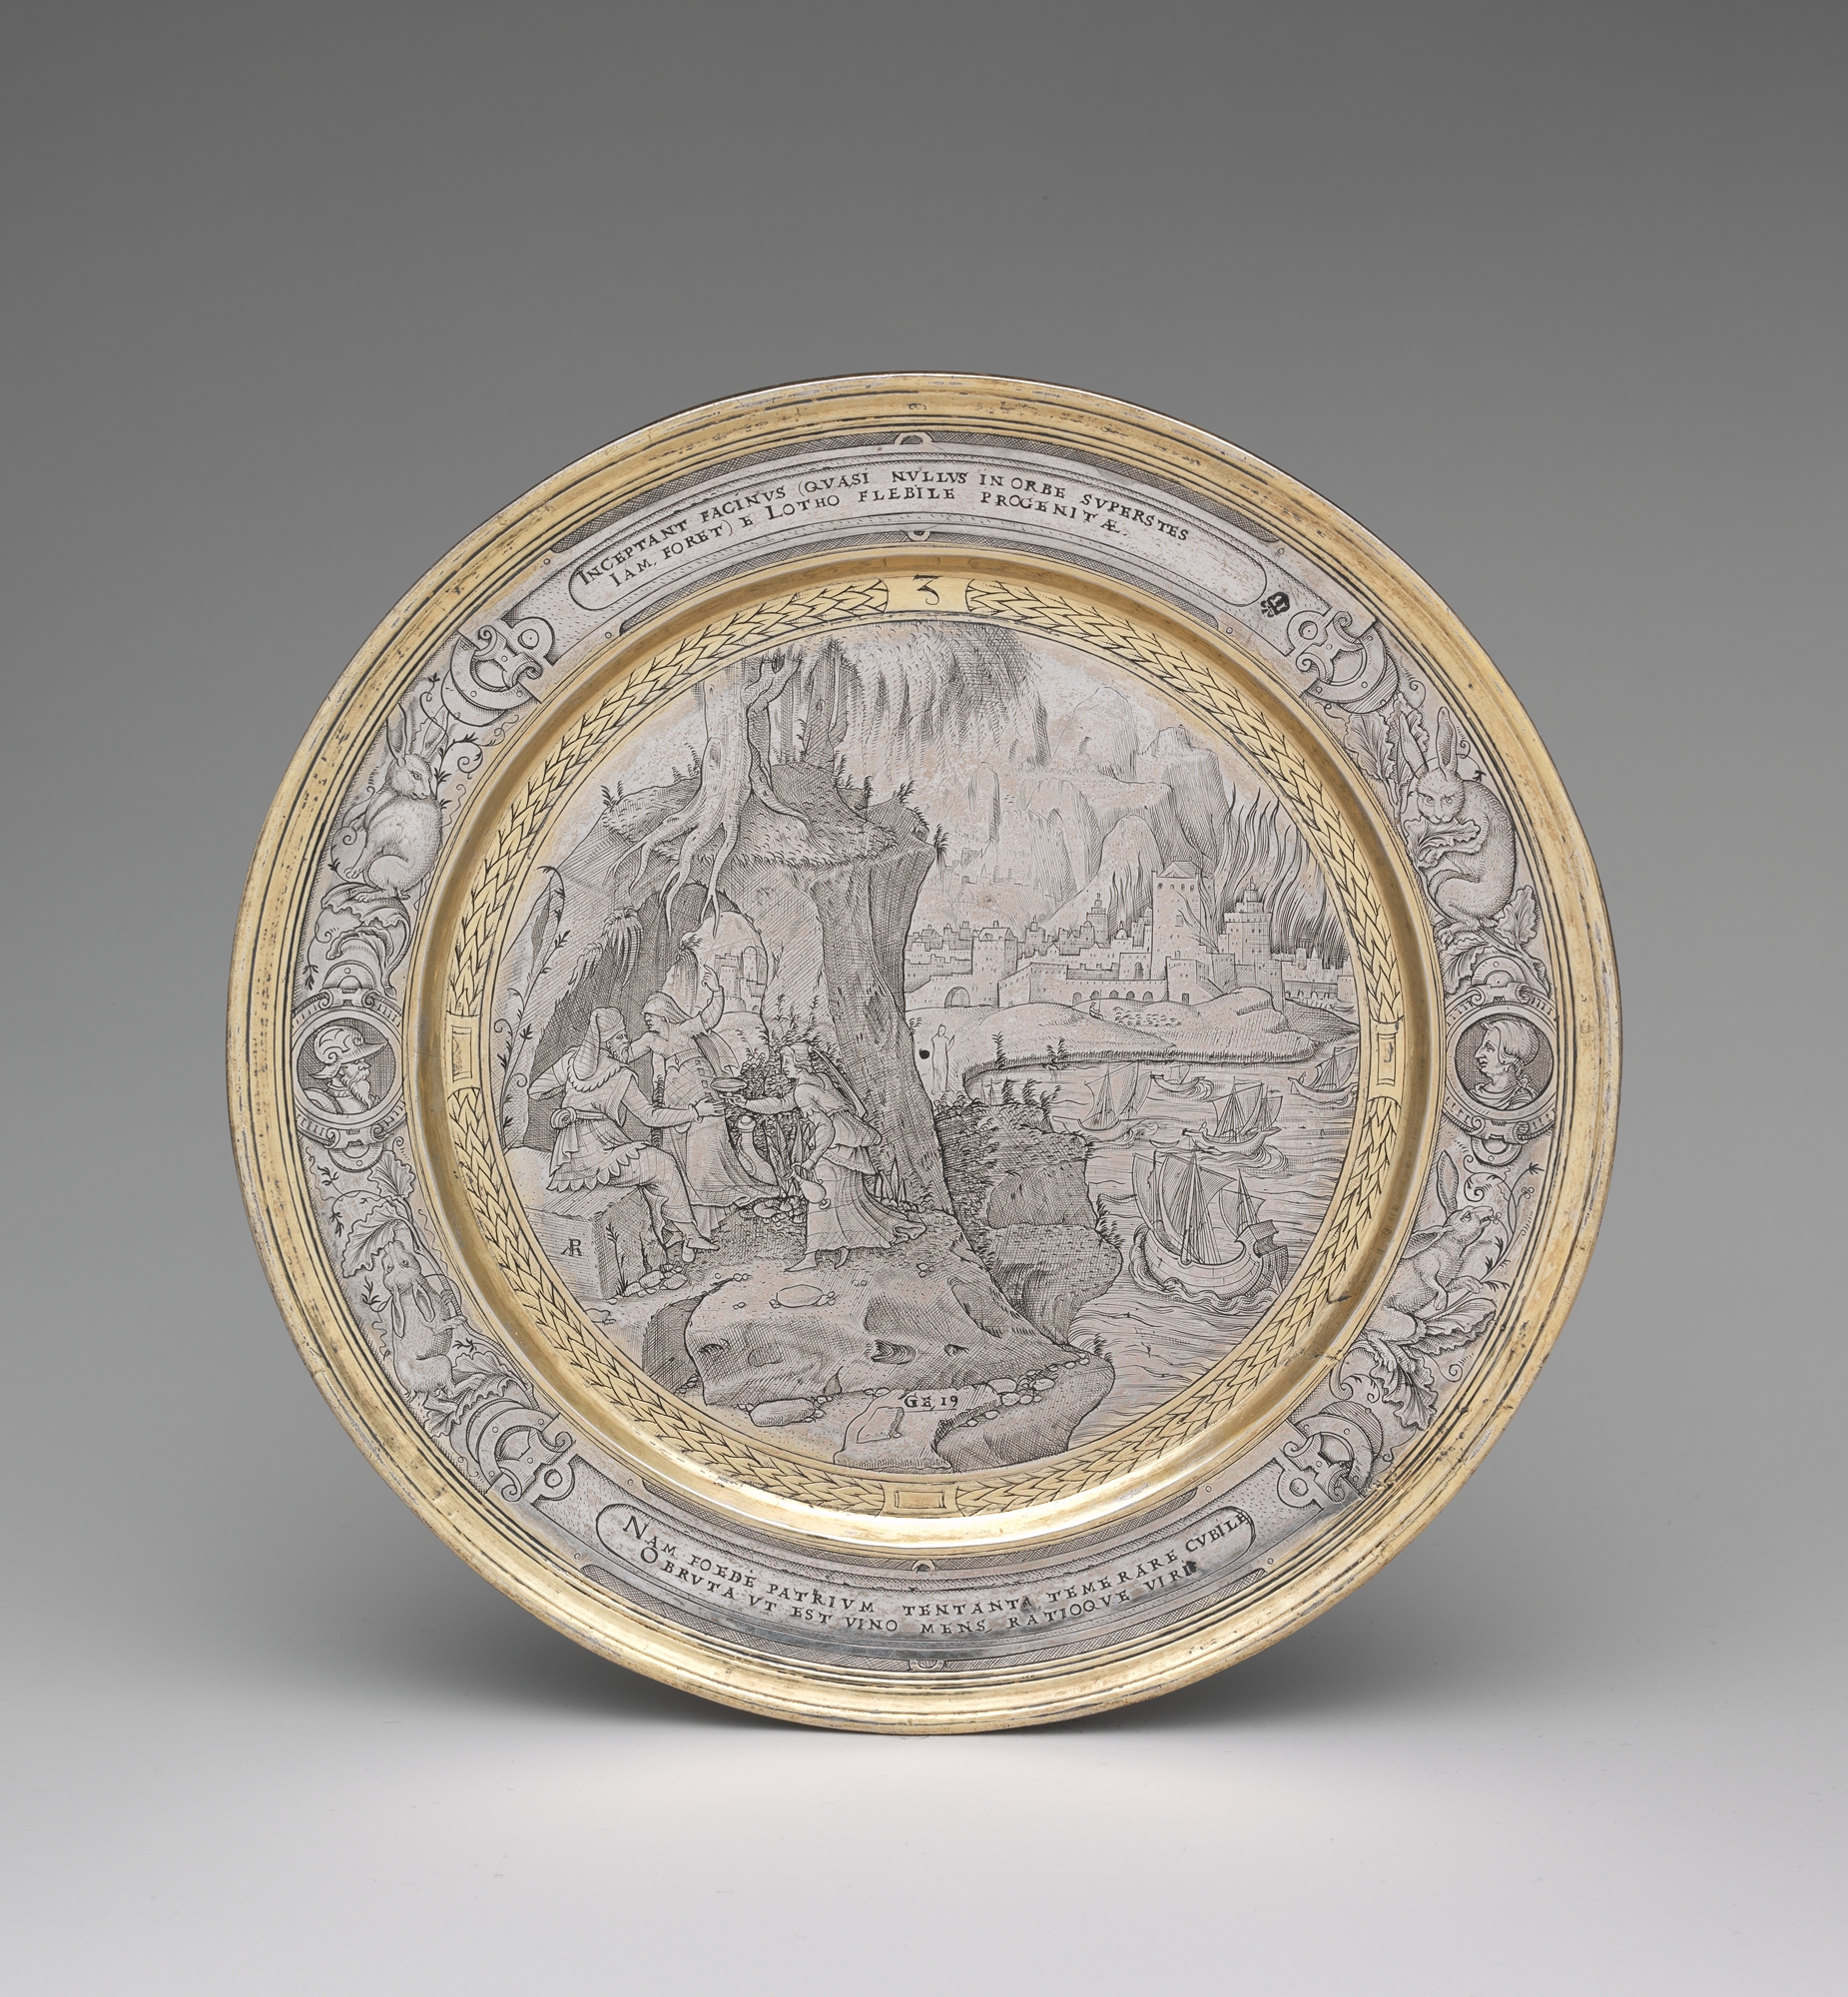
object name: plate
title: Lot Seduced by his Daughters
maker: p.m.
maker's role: engraver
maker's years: 1500-1600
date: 1567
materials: silver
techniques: gilding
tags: cities,men,women,fire,boats